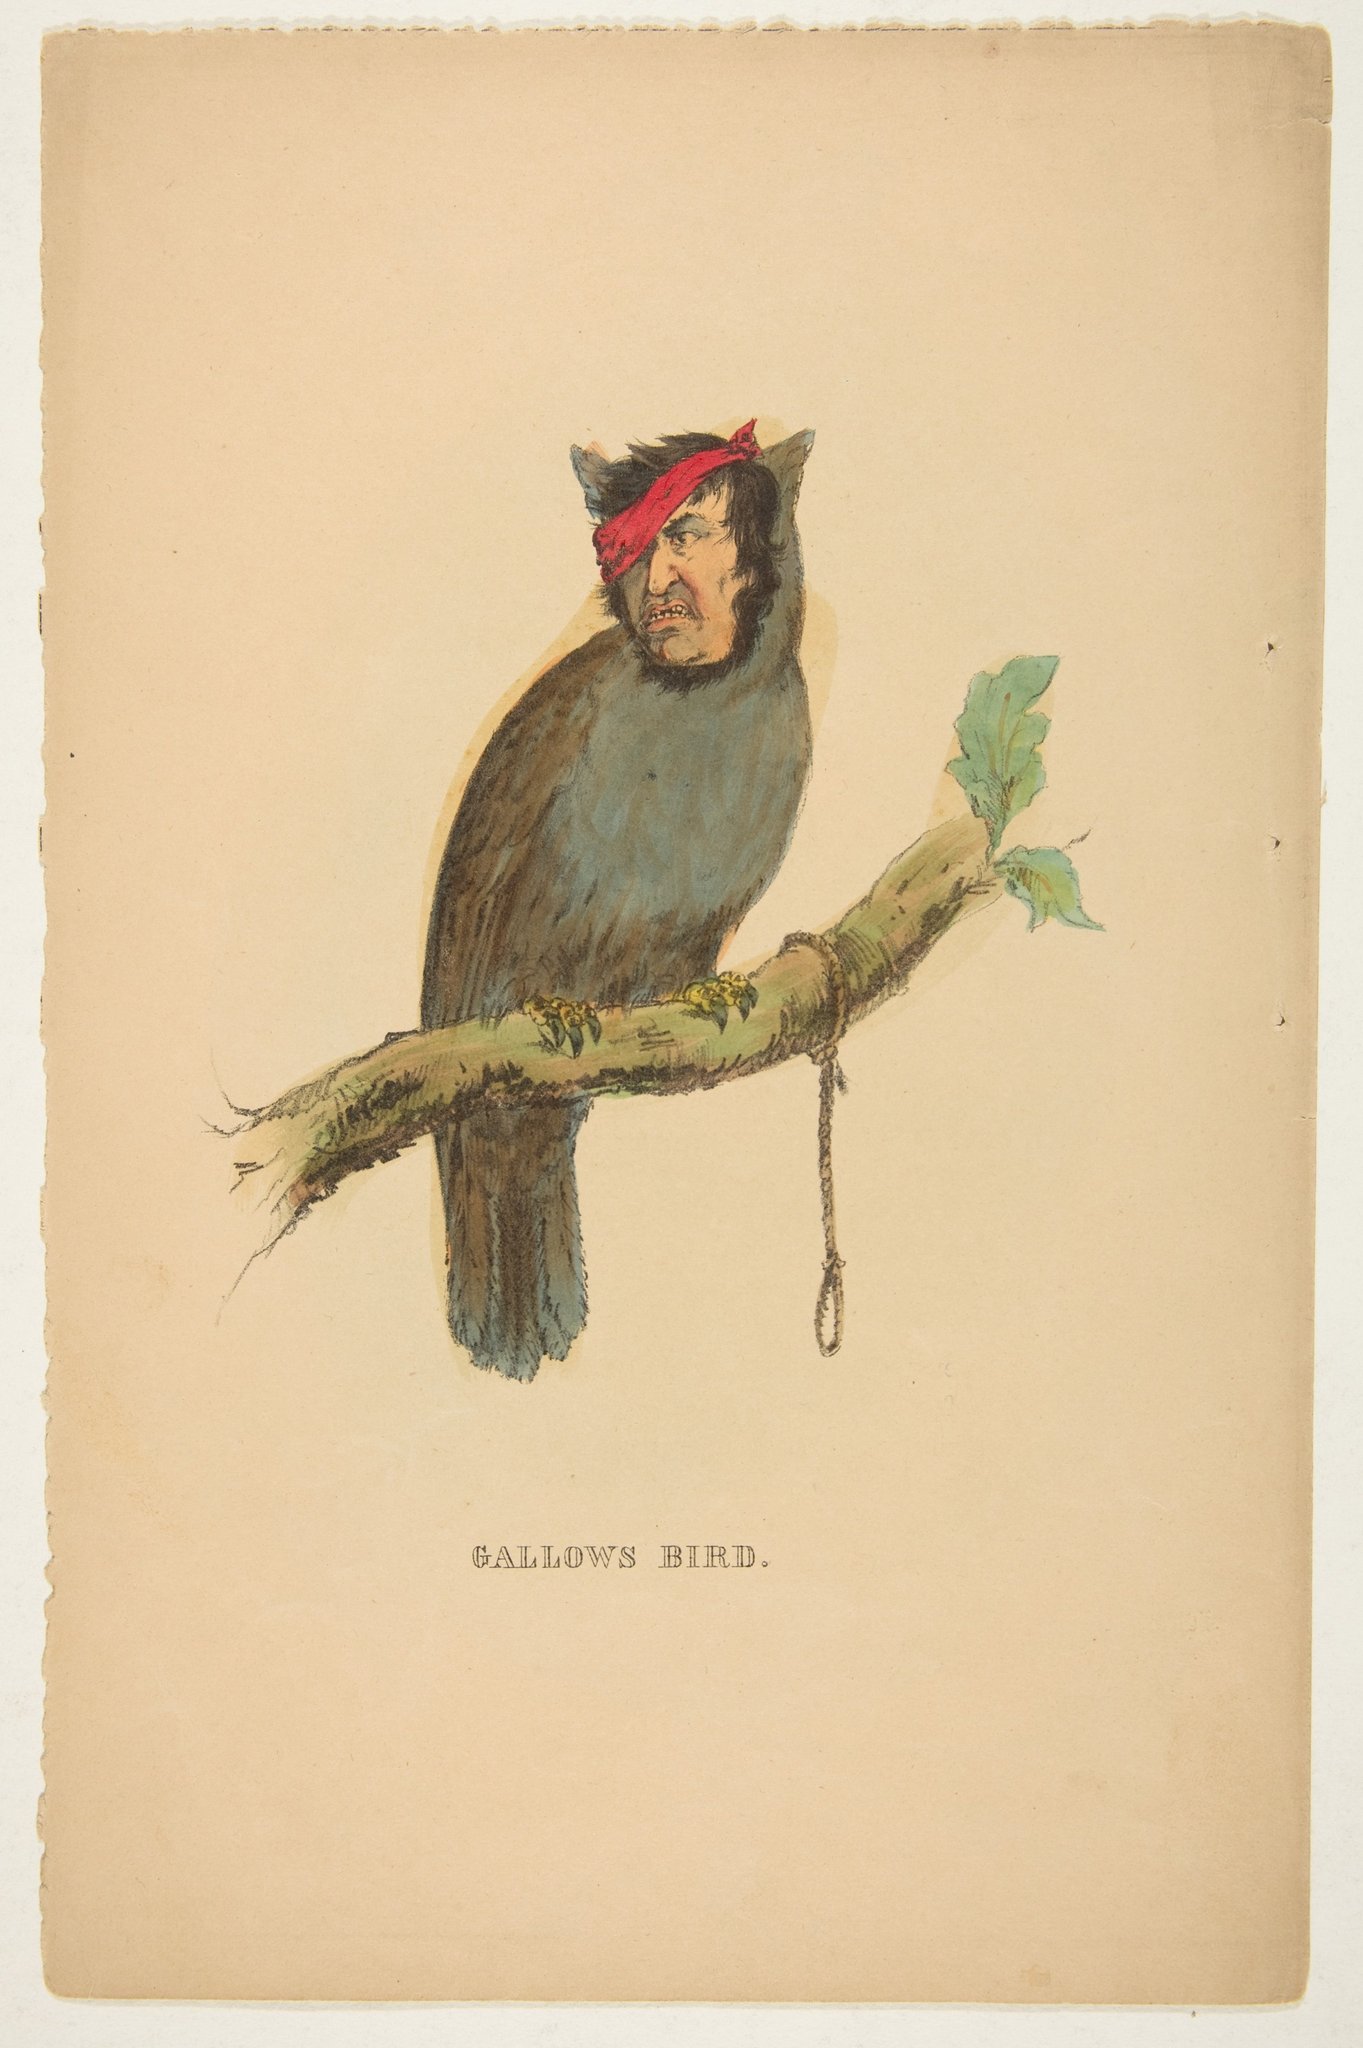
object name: print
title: Gallows Bird, from "The Comic Natural History of the Human Race"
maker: henry louis stephens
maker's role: artist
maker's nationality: american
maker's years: 1824-1882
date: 1851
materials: watercolor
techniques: lithograph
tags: satire